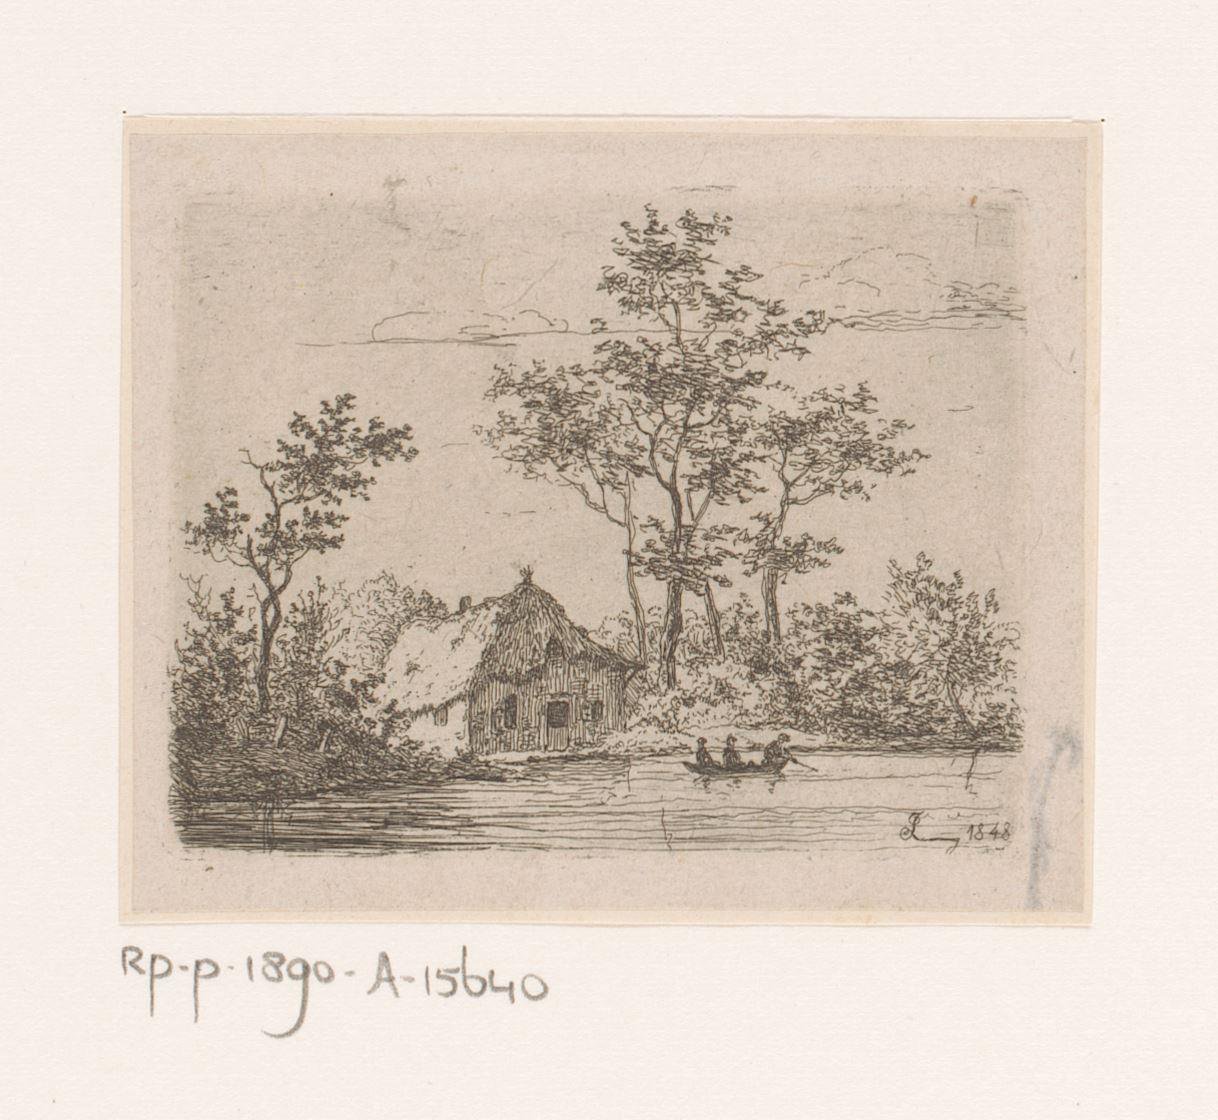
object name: print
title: Landschap bij Pont-à-Celles met een klein gebouw aan het water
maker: jean théodore joseph linnig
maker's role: draughtsman, print maker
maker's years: 1815-1891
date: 1848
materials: paper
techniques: etching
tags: river, rowing-boat, canoe, etc., hut, cabin, lodge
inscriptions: collector's mark: Lugt 2228